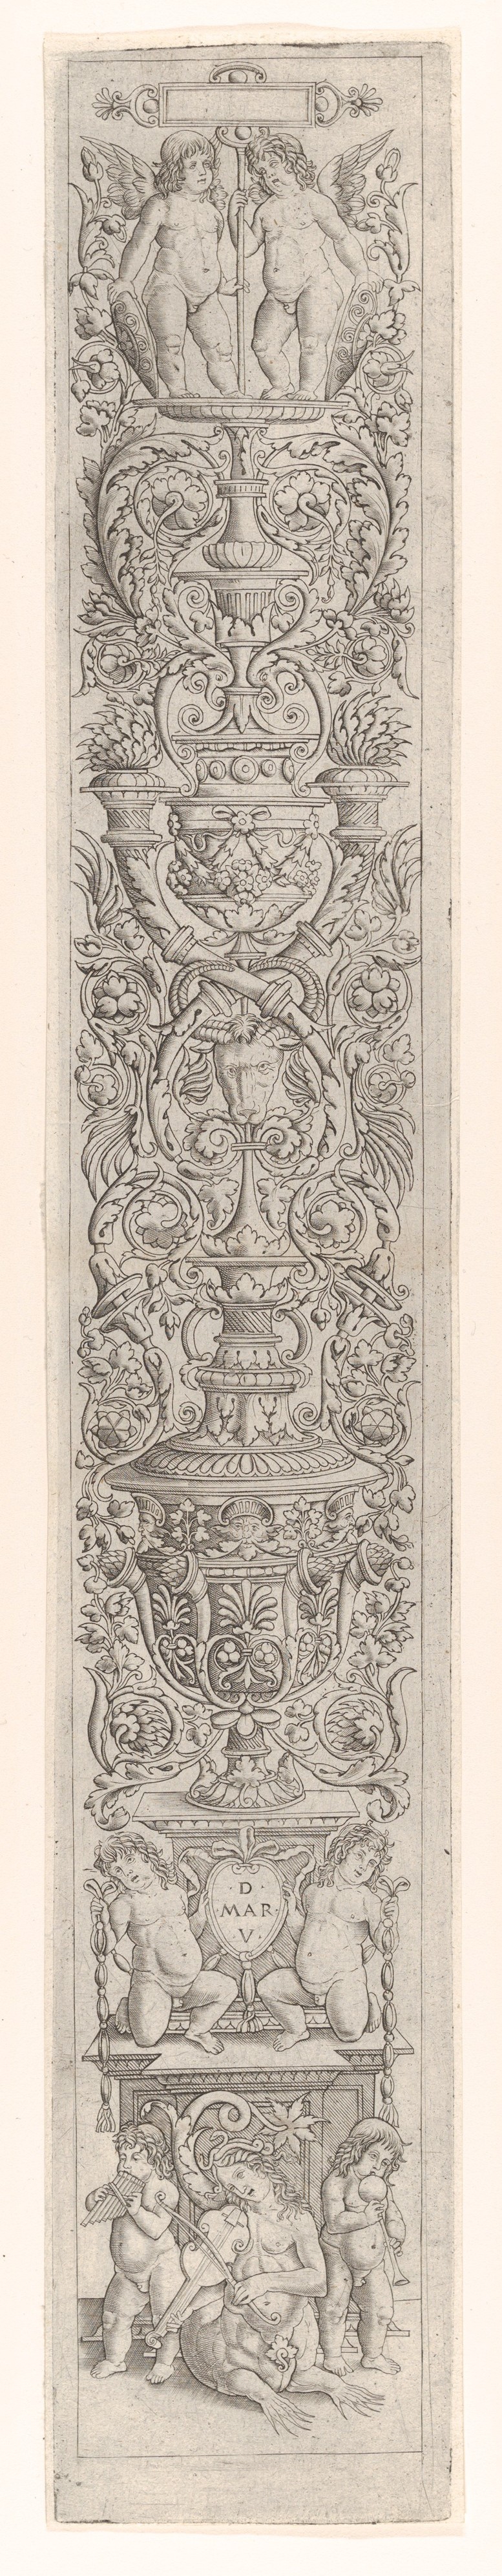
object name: print ornament architecture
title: A Nereid and Two Children Playing Musical Instruments, from Twelve Ornamental Panels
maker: giovanni antonio da brescia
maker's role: artist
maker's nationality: italian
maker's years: 1490-1525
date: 1490-1515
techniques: engraving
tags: musical instruments,infants